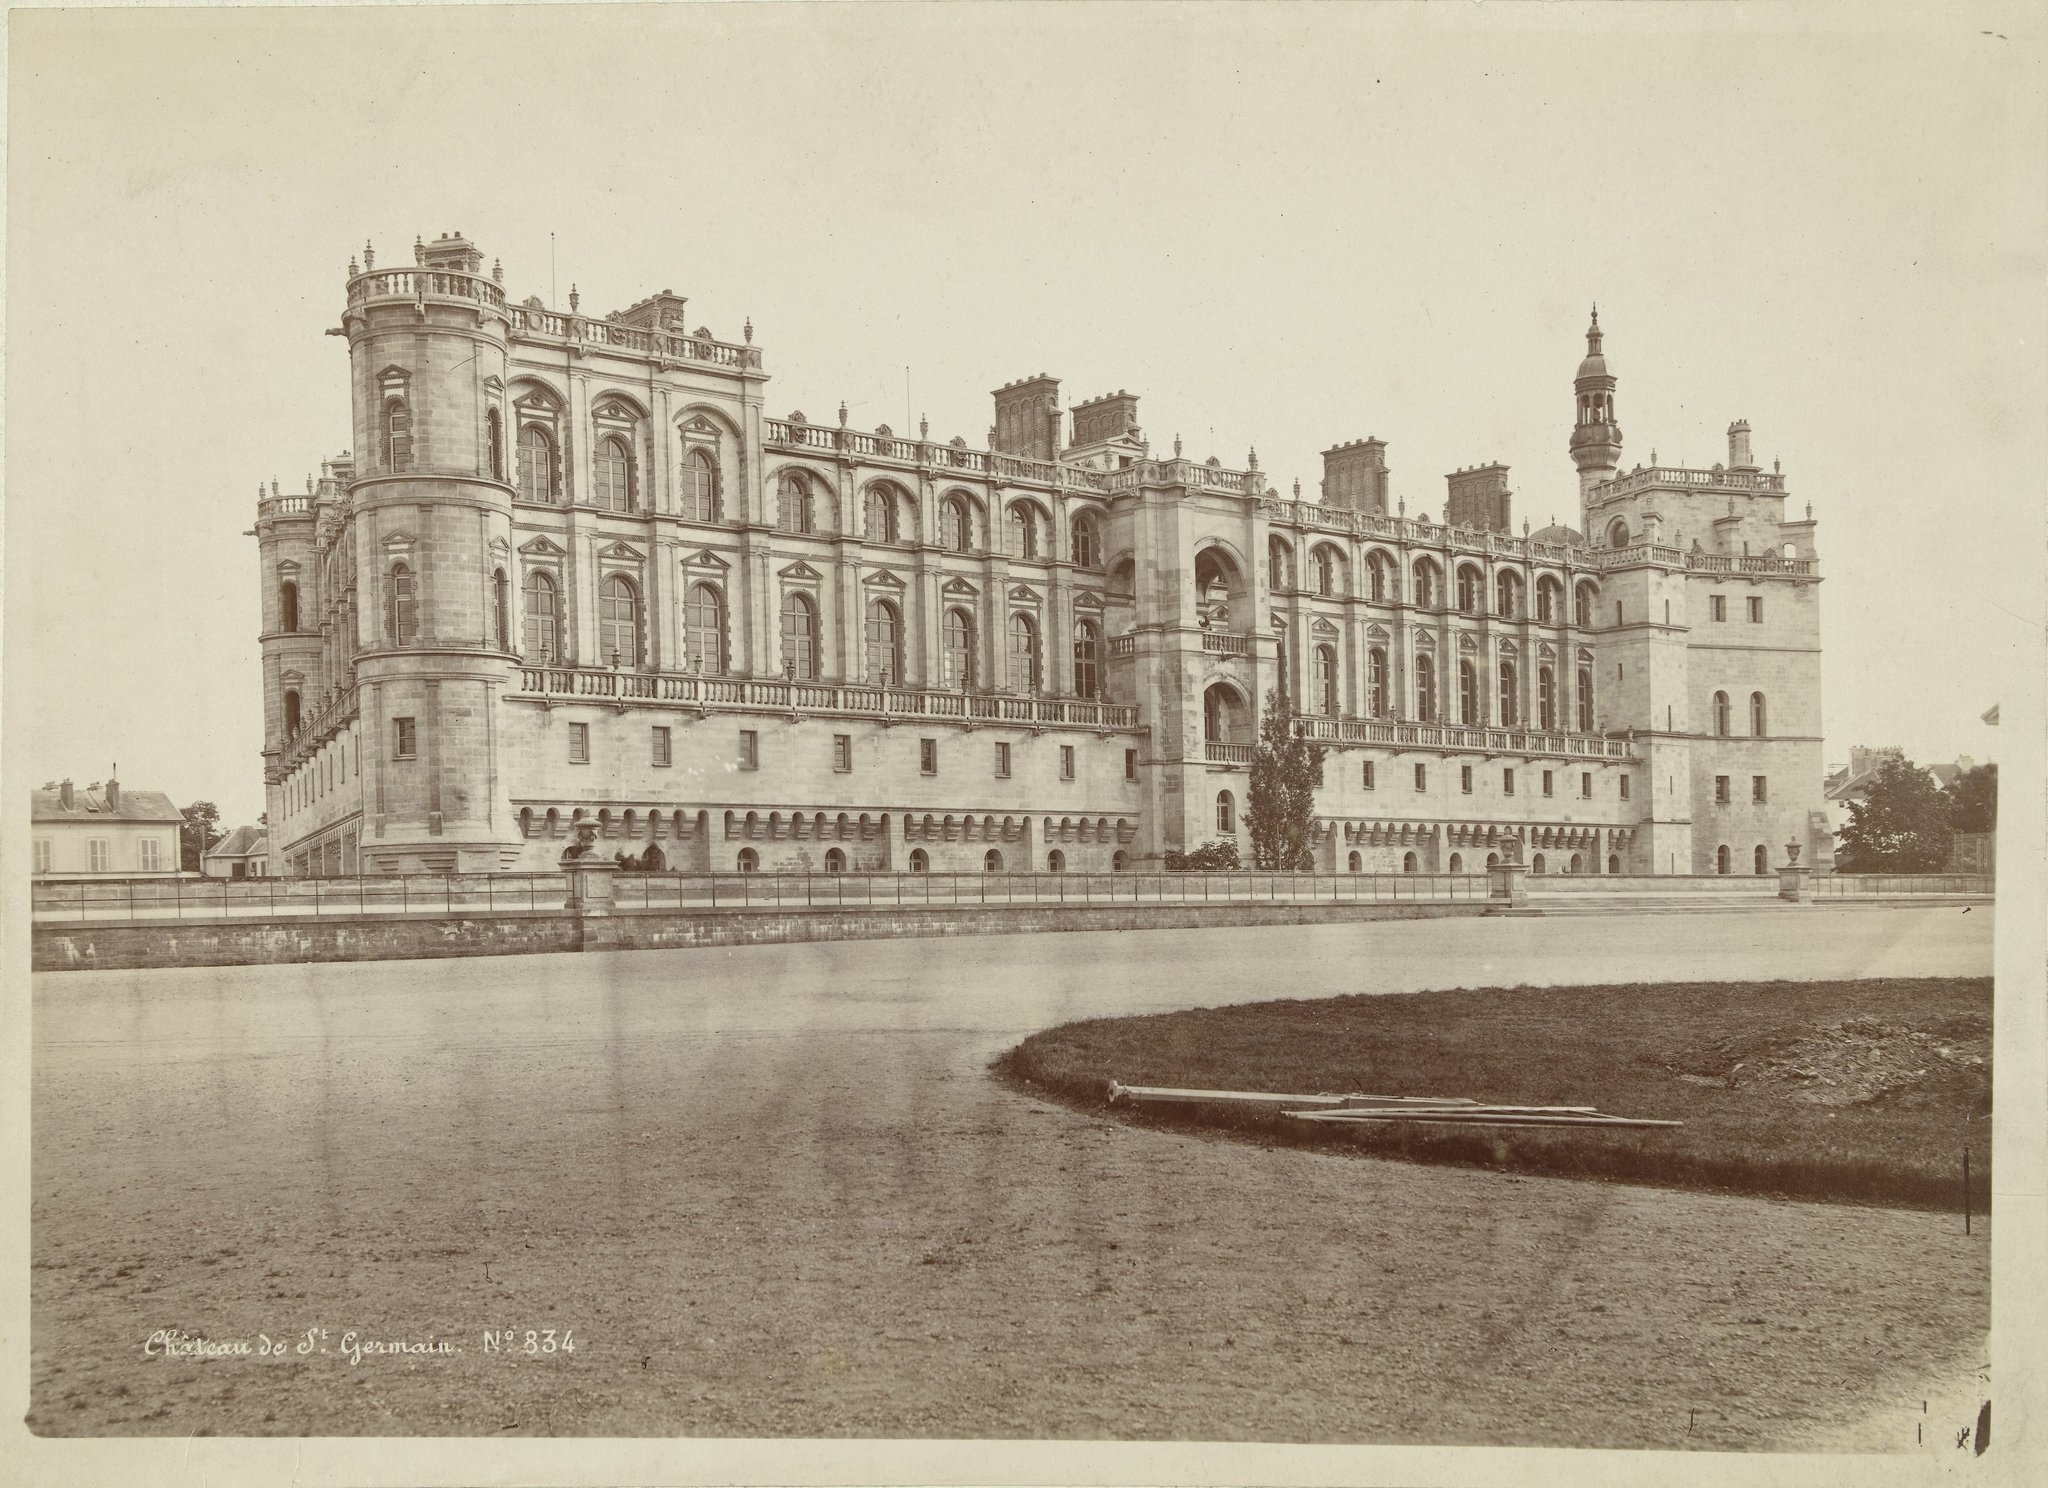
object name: photograph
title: Château de St. Germain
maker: séraphin-médéric mieusement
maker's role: fotograaf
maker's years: 1840-1905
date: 1870-1890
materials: cardboard, paper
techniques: albumen print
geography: saint-germain-en-laye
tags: castle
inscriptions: inscription: ‘13e E.’, inscription: ‘Château de St. Germain No. 834’, collector's mark: Lugt 3937, check stamp: ‘Mieusement/ Photographe’